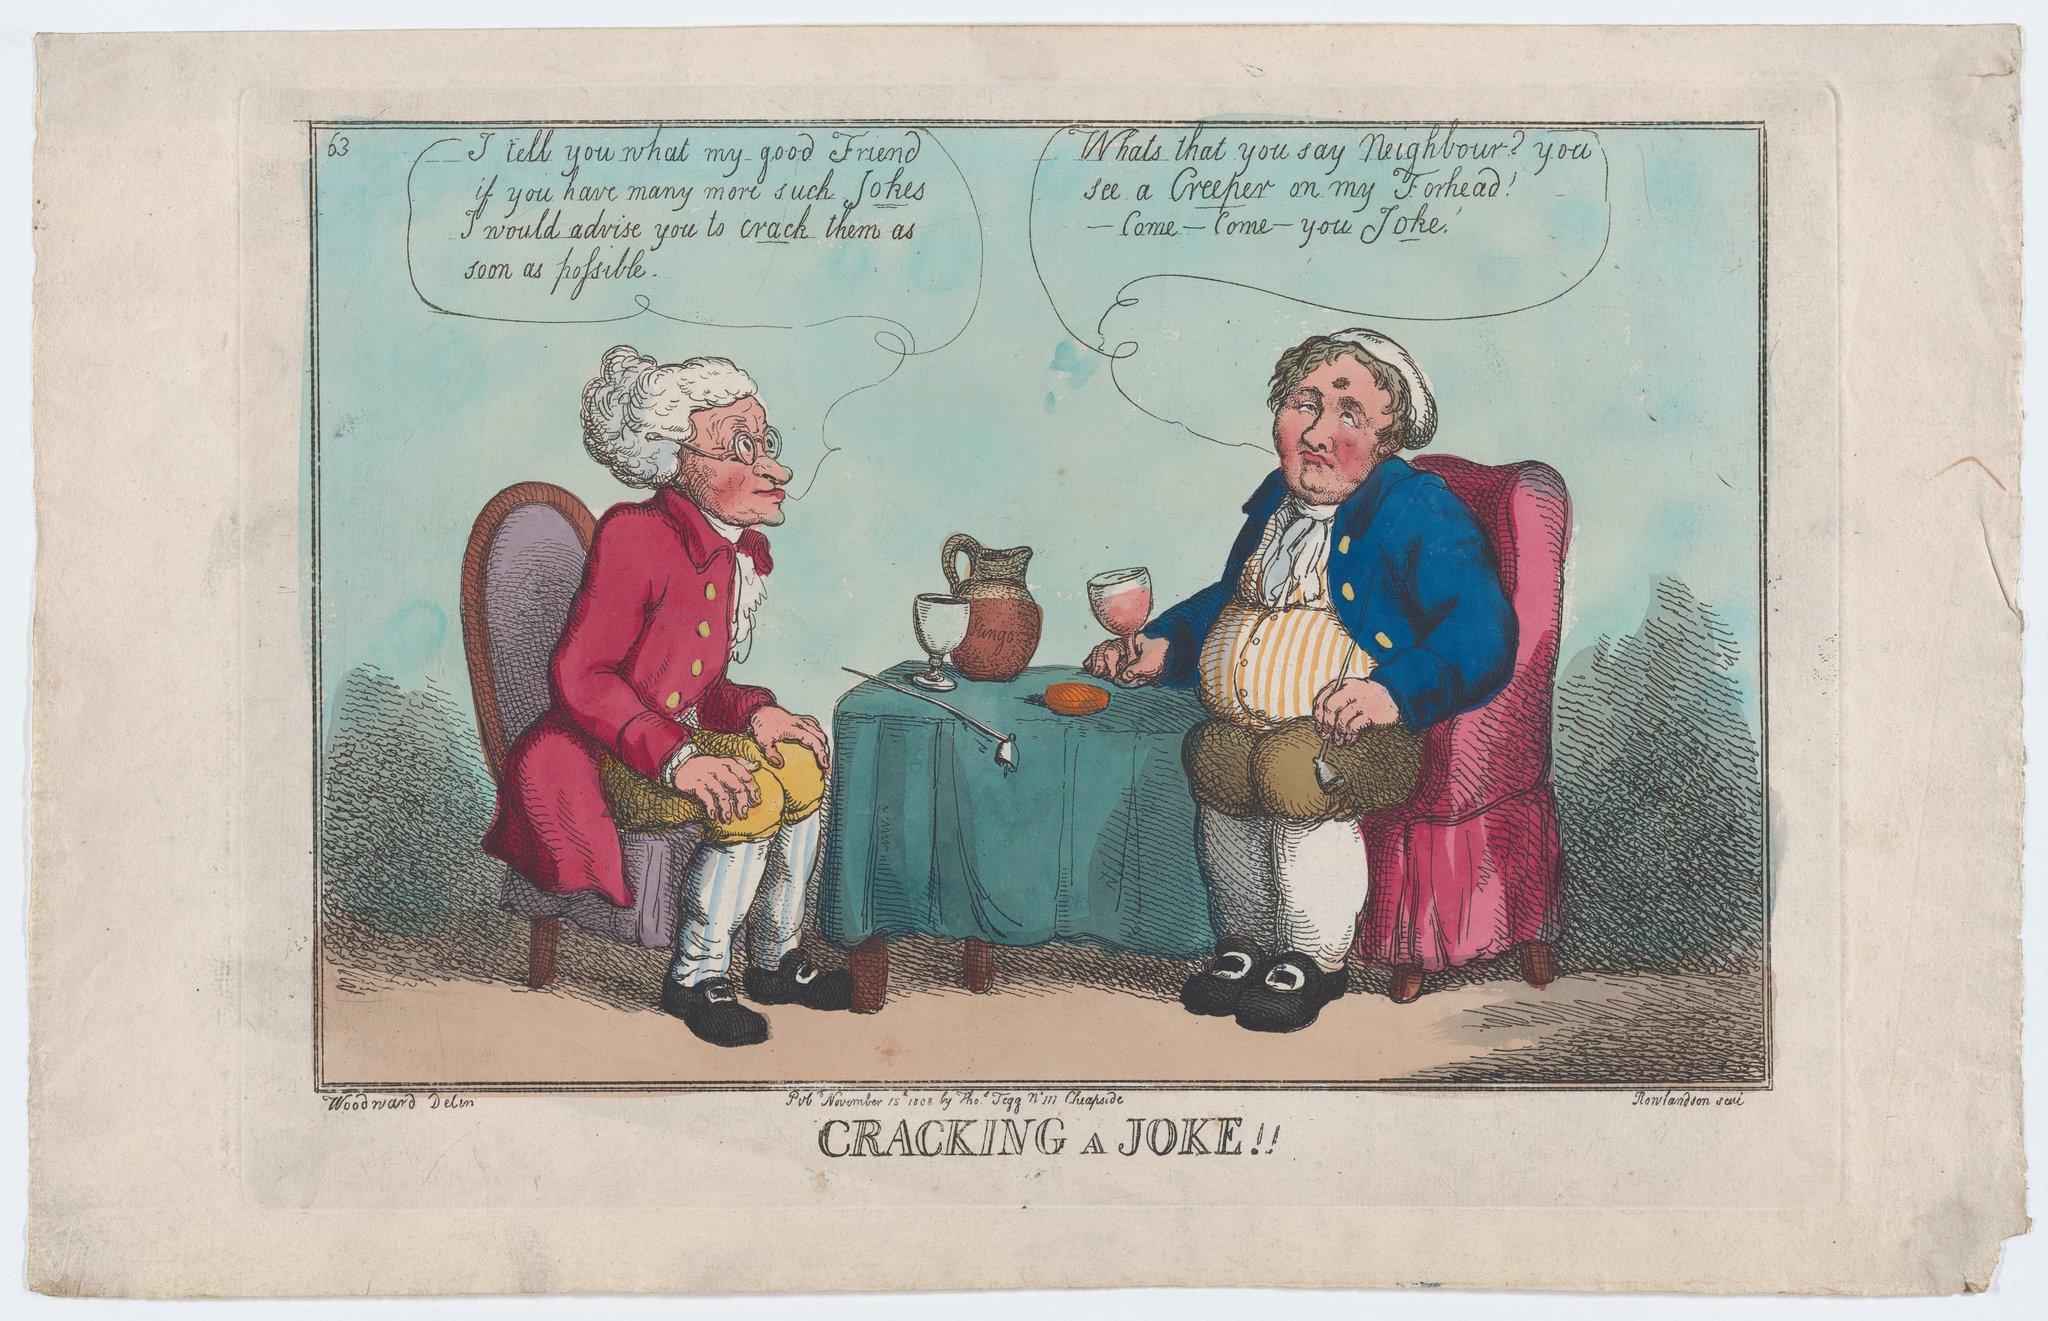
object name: print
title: Cracking a Joke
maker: thomas rowlandson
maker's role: artist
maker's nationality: british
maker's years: 1757-1827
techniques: etching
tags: satire,men